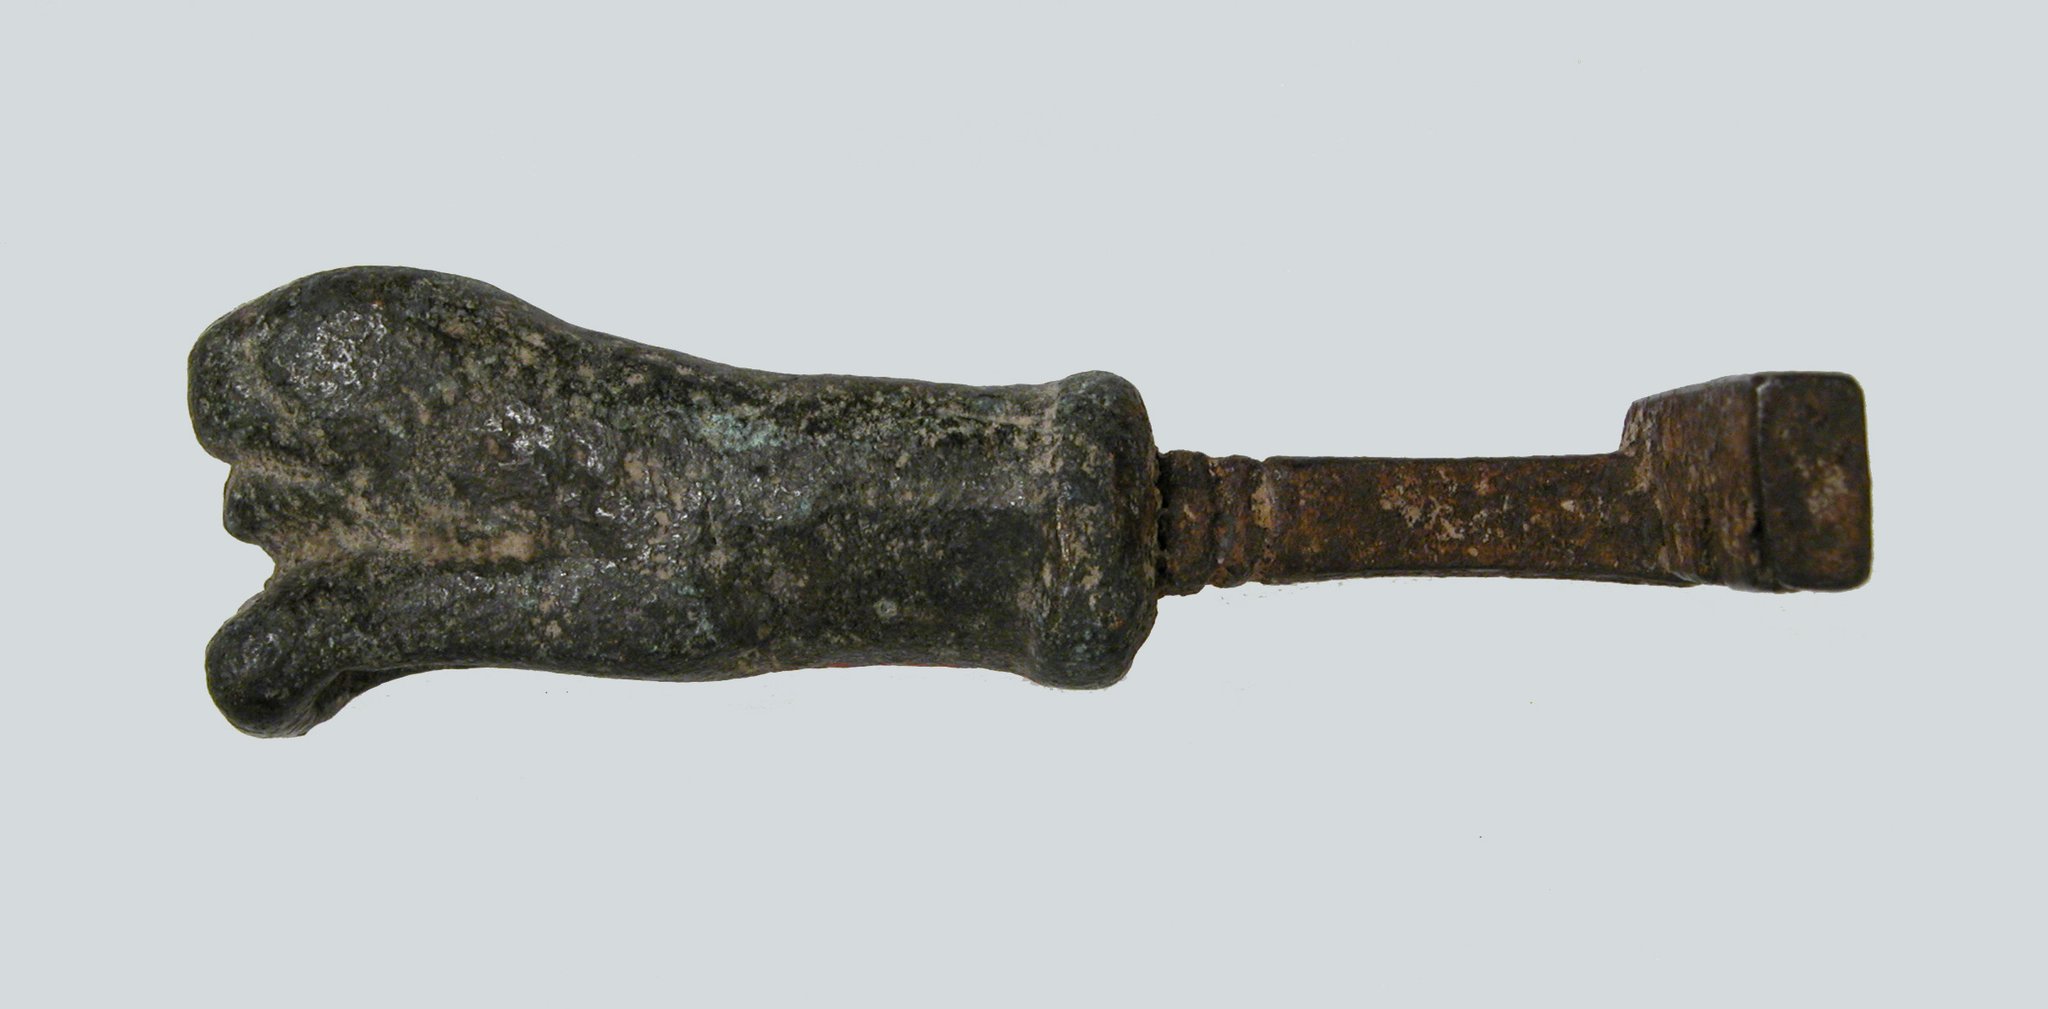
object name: key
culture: roman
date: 1-700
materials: copper alloy, iron